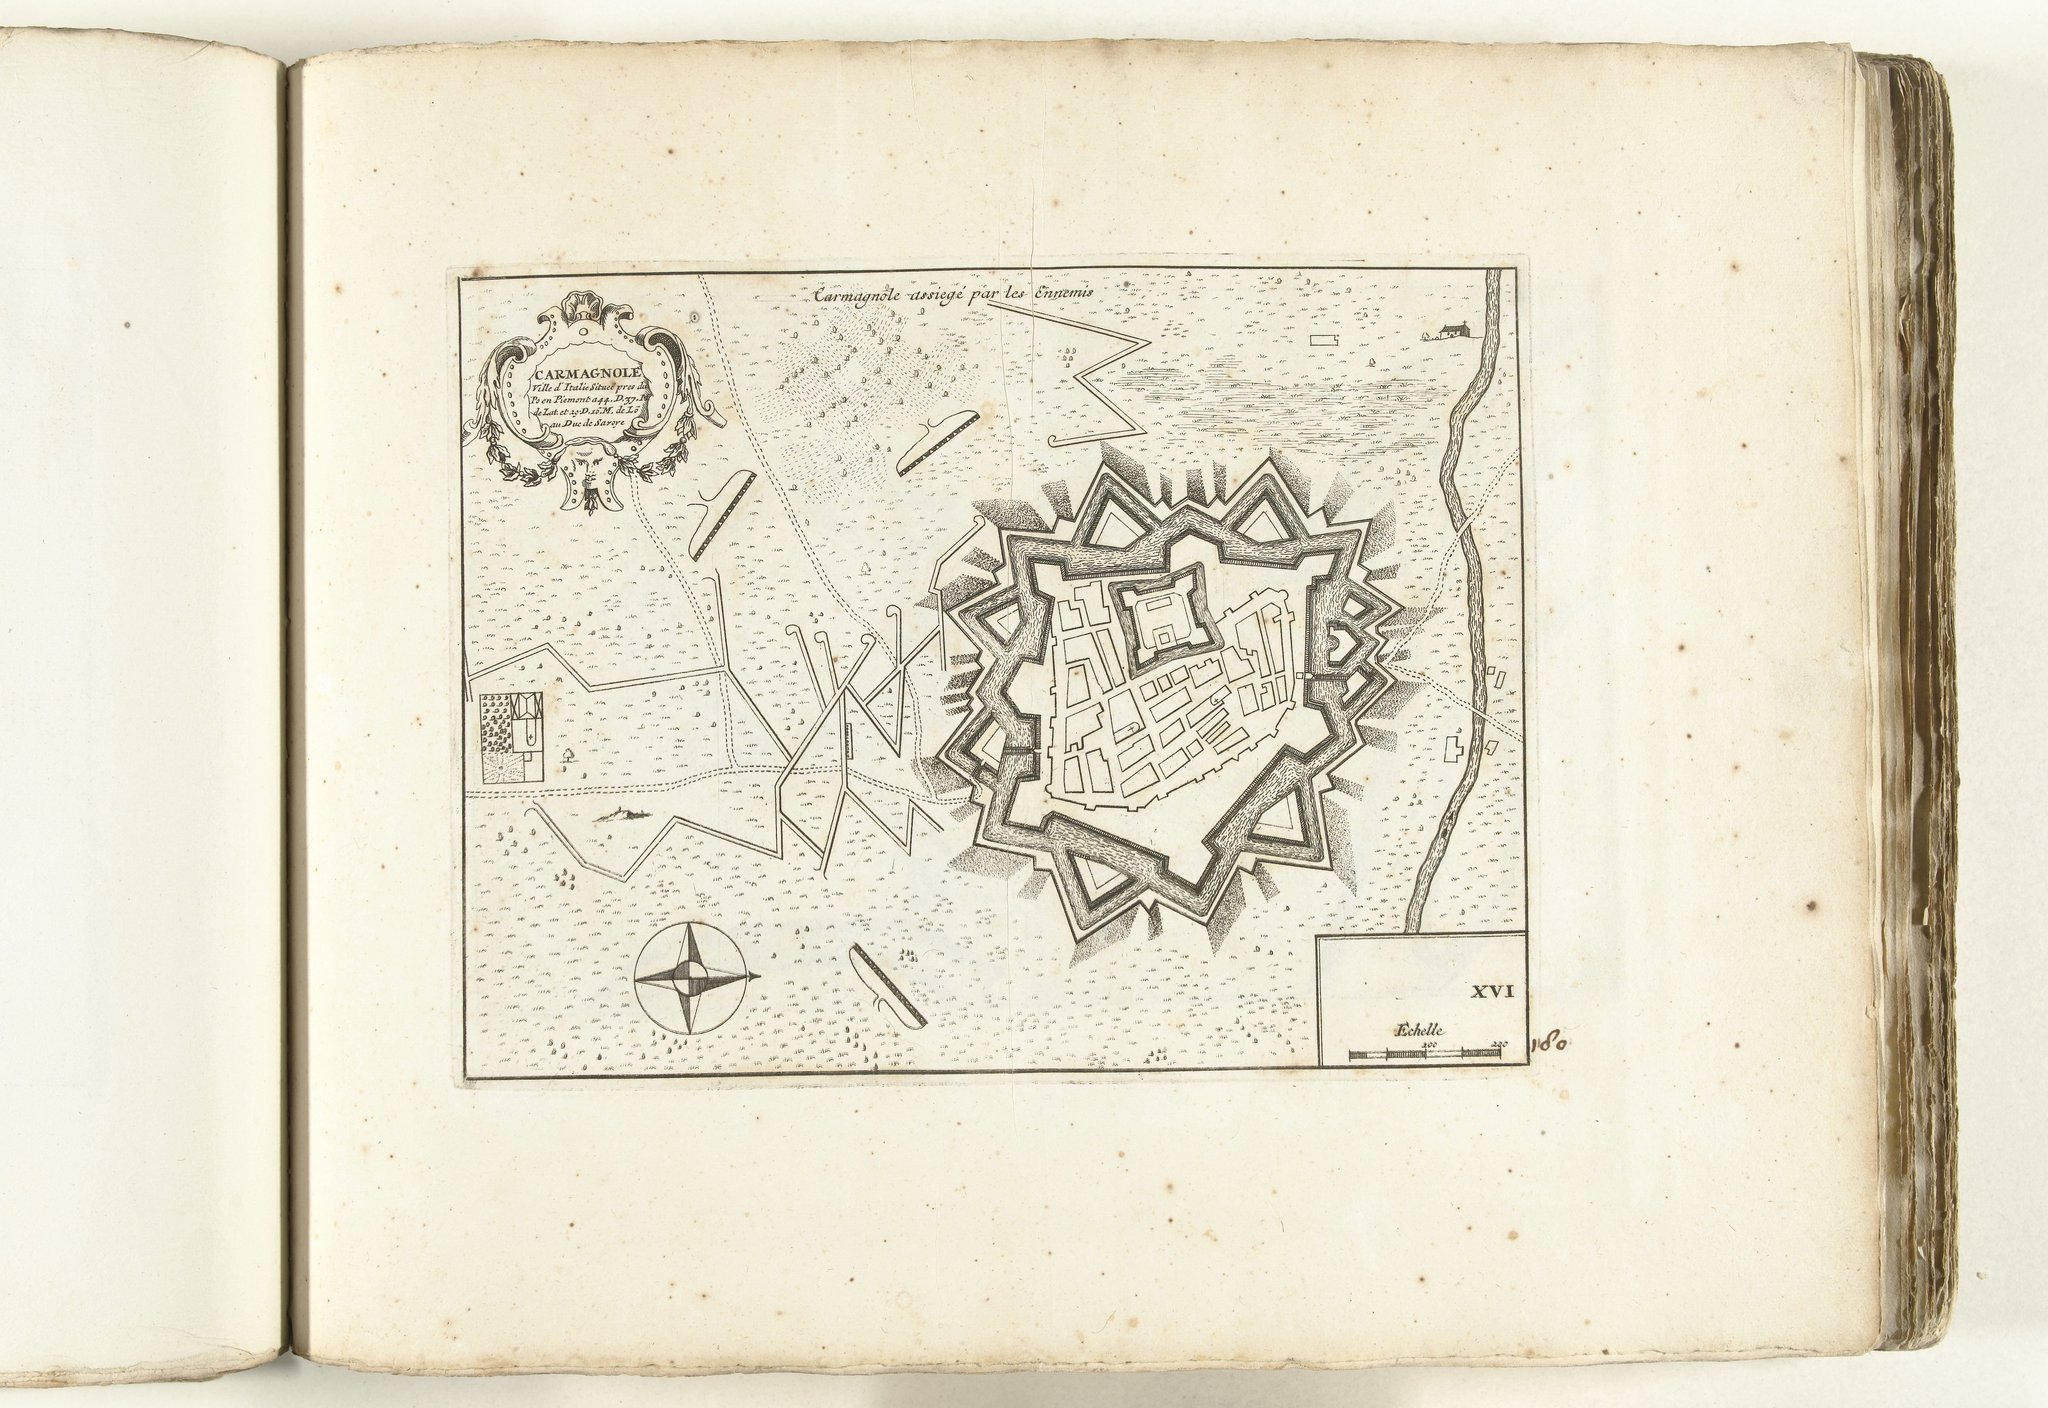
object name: map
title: Plattegrond van Carmagnola, ca. 1702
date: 1702-1703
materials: paper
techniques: etching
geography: amsterdam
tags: fortress, maps of cities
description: Plattegrond met de loopgraven van de belegeraars en de versterkingen om de Italiaanse stad Carmagnola tijdens de belegering. Plaat nr. 180 in het prentwerk bestaande in totaal uit 276 genummerde platen van vermaarde sterke steden en vestingen in het kader van de Spaanse Successieoorlog. Voor het merendeel zijn deze platen gekopieerd naar de anonieme Franse platen: in Les forces de l'Europe en in: Le theatre de la guerre, dans les Pays-Bas, beide oorspronkelijk uitgegeven door Nicolas de Fer te Parijs (1693-1697) in het kader van de Negenjarige Oorlog. Titel en opschriften in de plaat in het Frans.